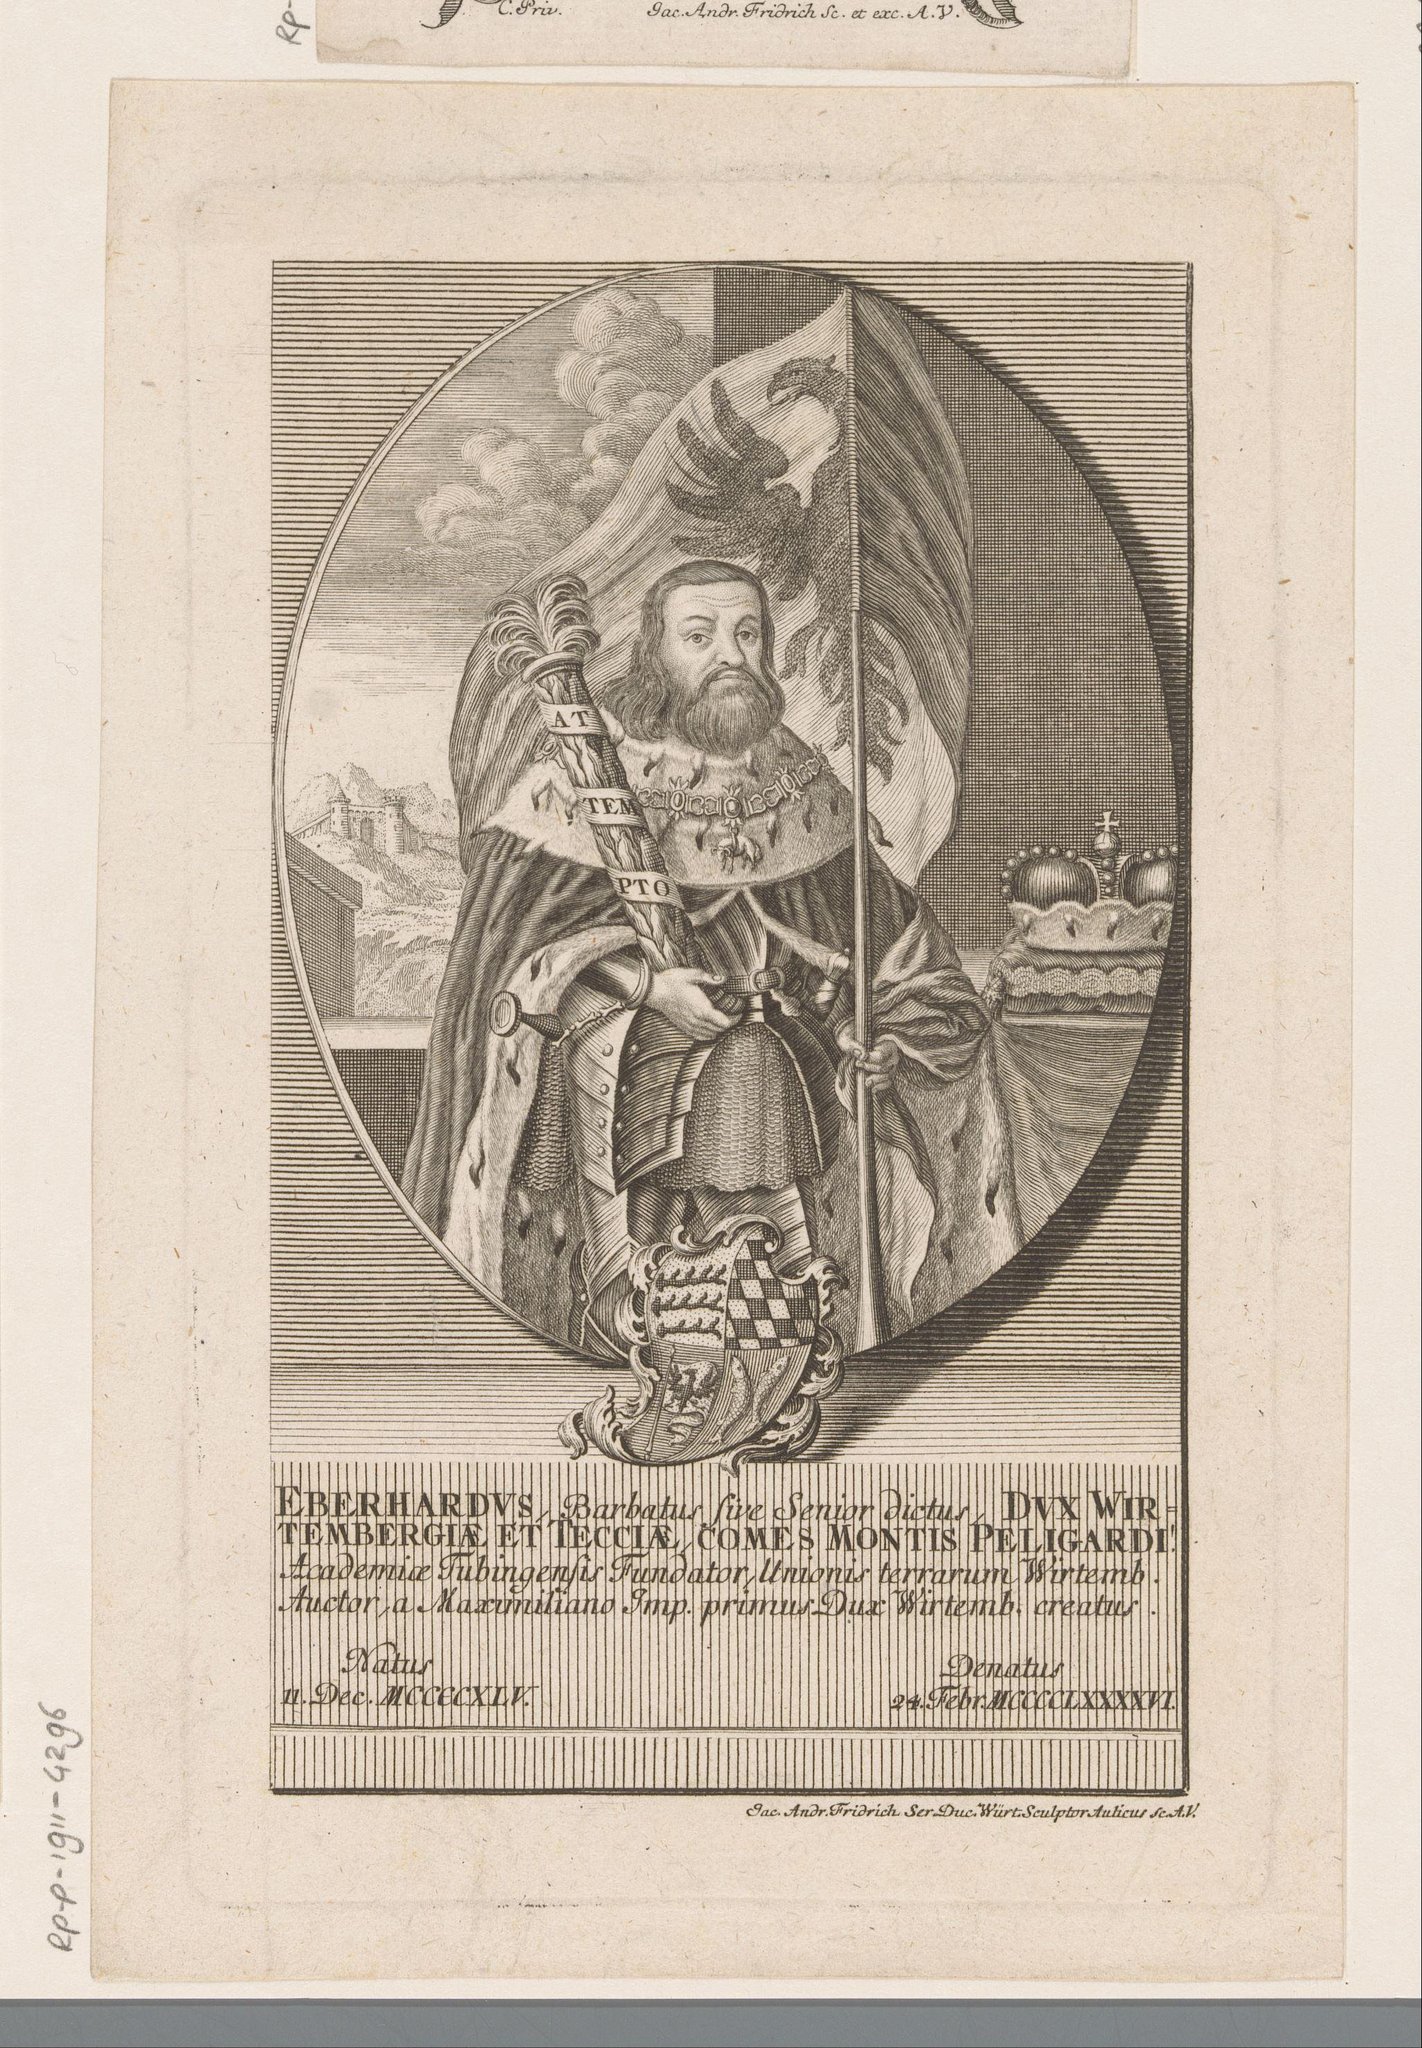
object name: print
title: Portret van Eberhard von Württemberg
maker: jacob andreas fridrich (ii)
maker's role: print maker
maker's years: 1714-1779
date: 1724-1779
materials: paper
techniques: engraving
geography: augsburg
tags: earl, historical persons, knighthood order of the golden fleece - insignia of a knighthood order, e.g.: badge, chain (with name of order), armorial bearing, heraldry, insignia and symbols of sovereignty (crown, diadem, sceptre, orb, seal, standard, cloak, pectoral)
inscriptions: collector's mark: Lugt 2228